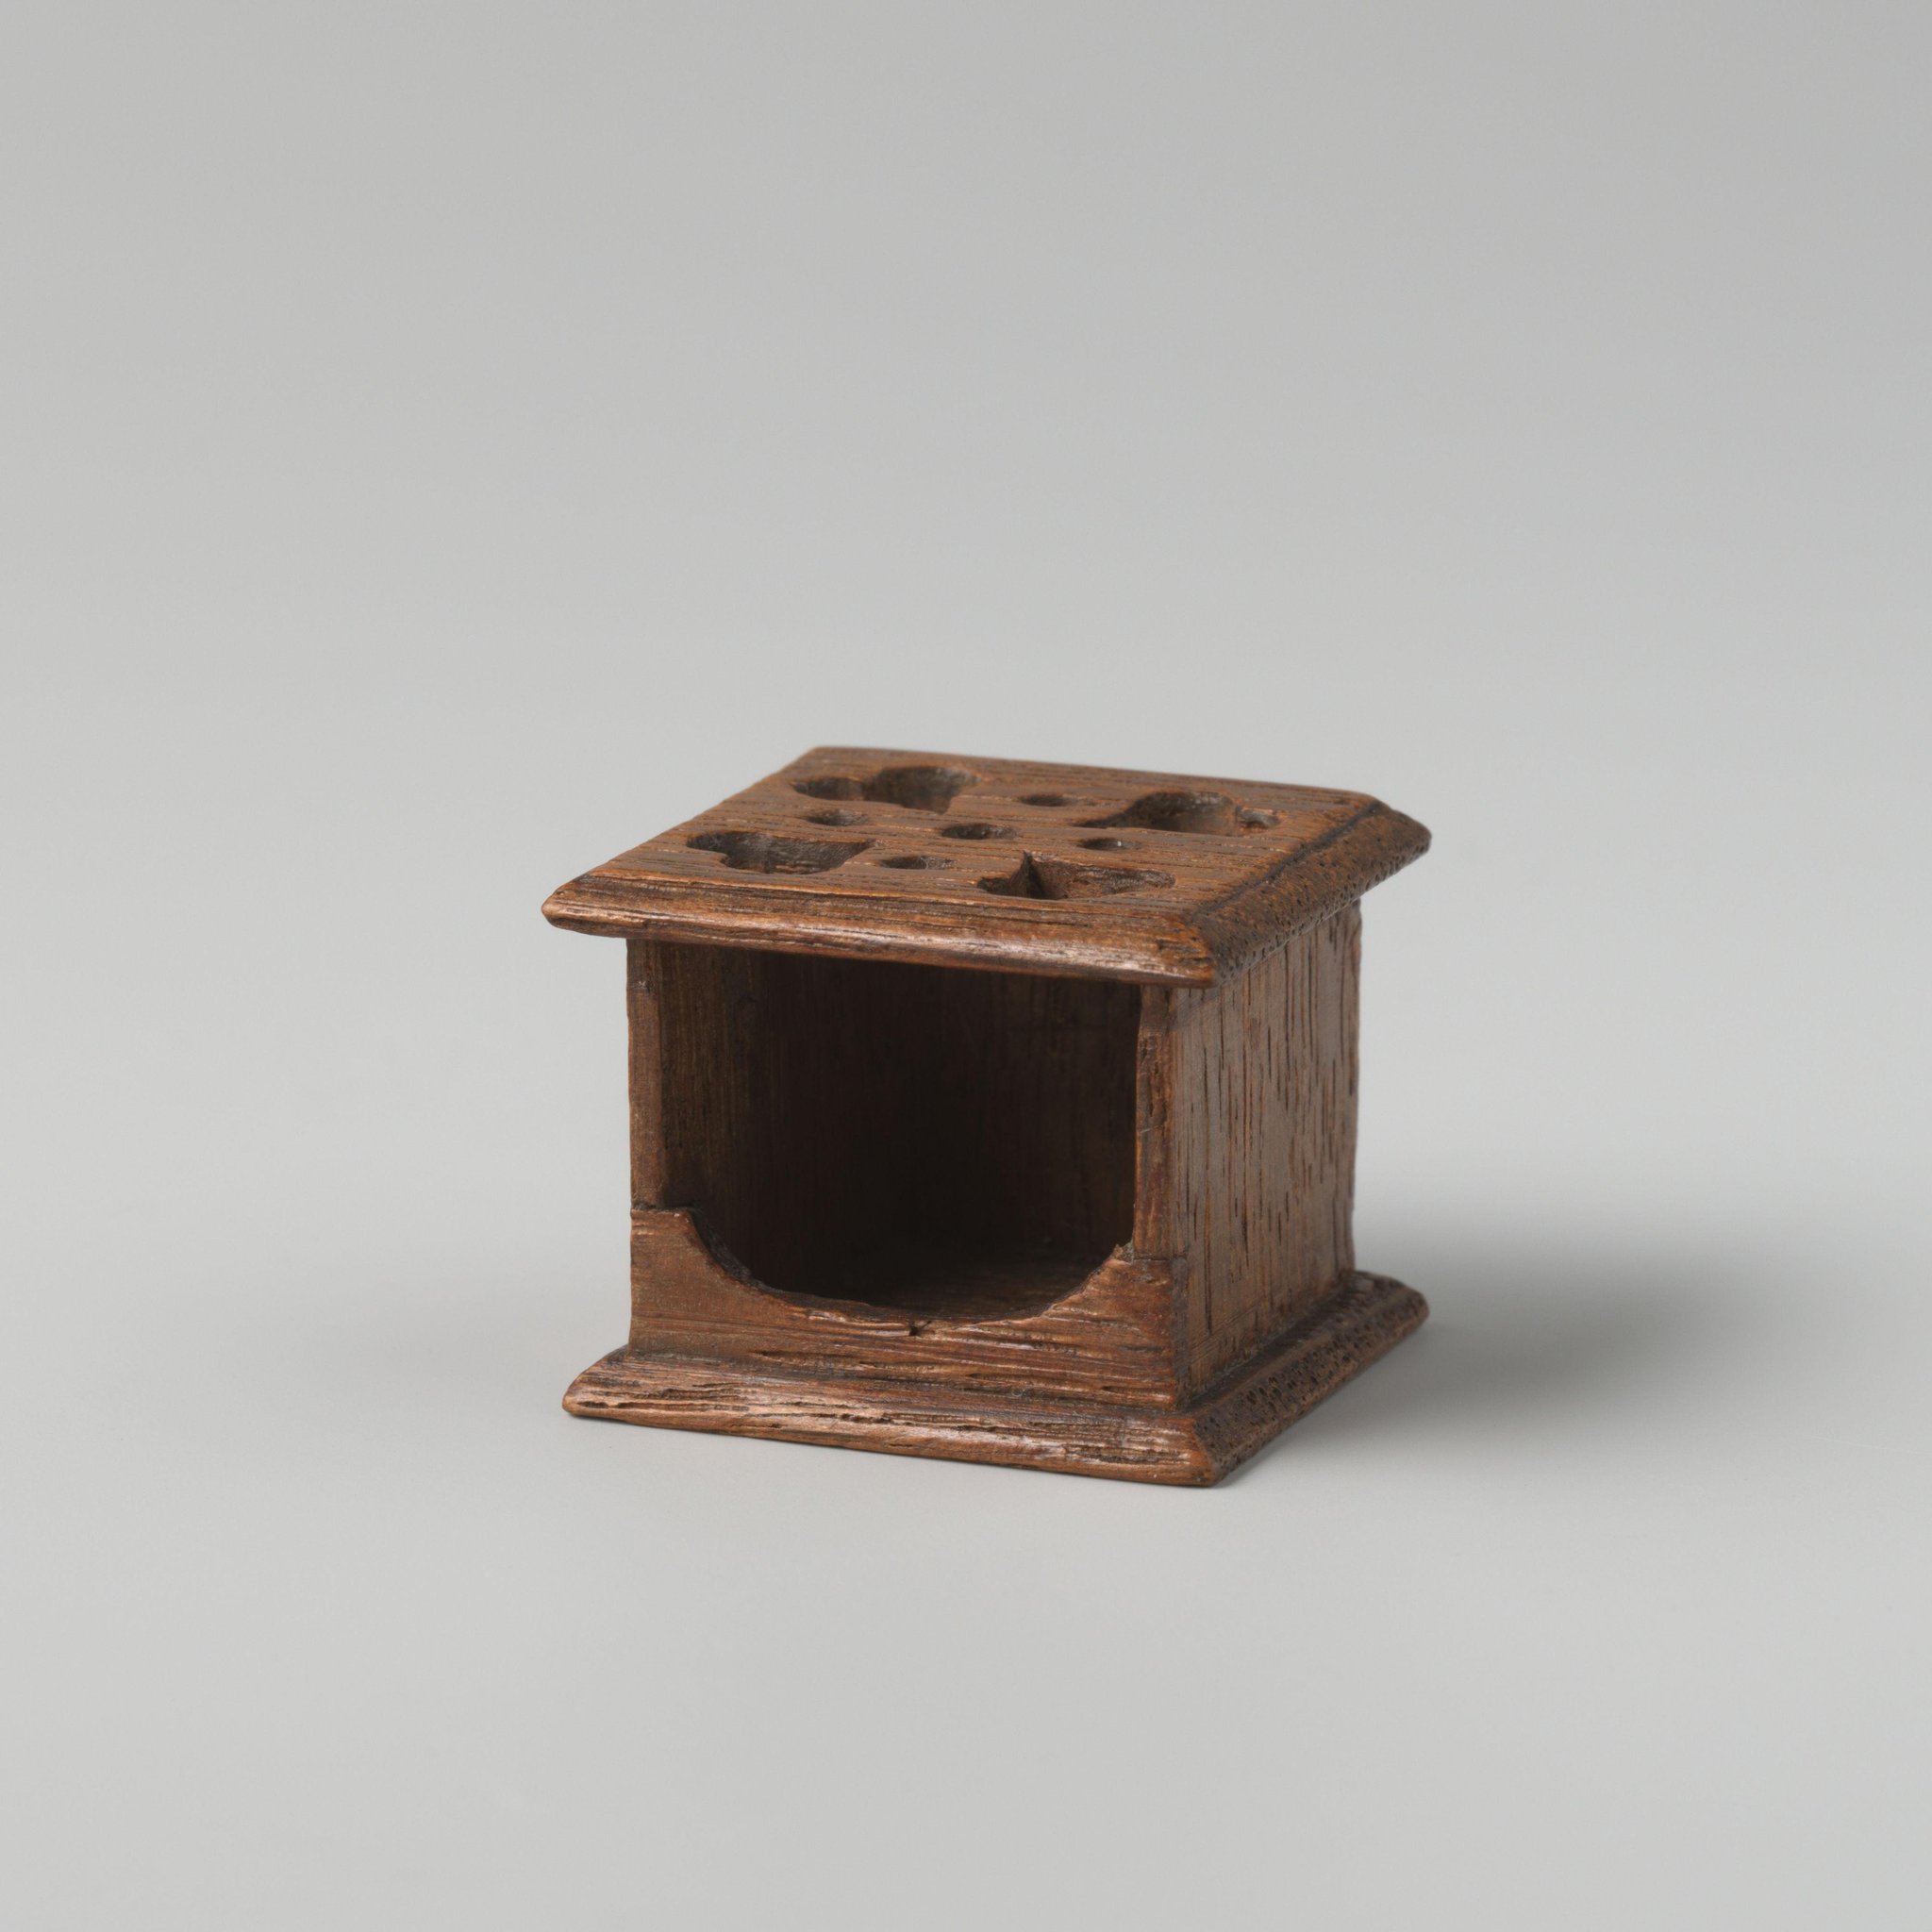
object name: miniature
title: Vierkante stoof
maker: Anonymous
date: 1690-1710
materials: wood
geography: amsterdam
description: Vierkante stoof van eikenhout. De stoof heeft een opstaande rand aan de voorzijde en in de voetenplank zijn vier hartvormige en vijf ronde gaten aangebracht.